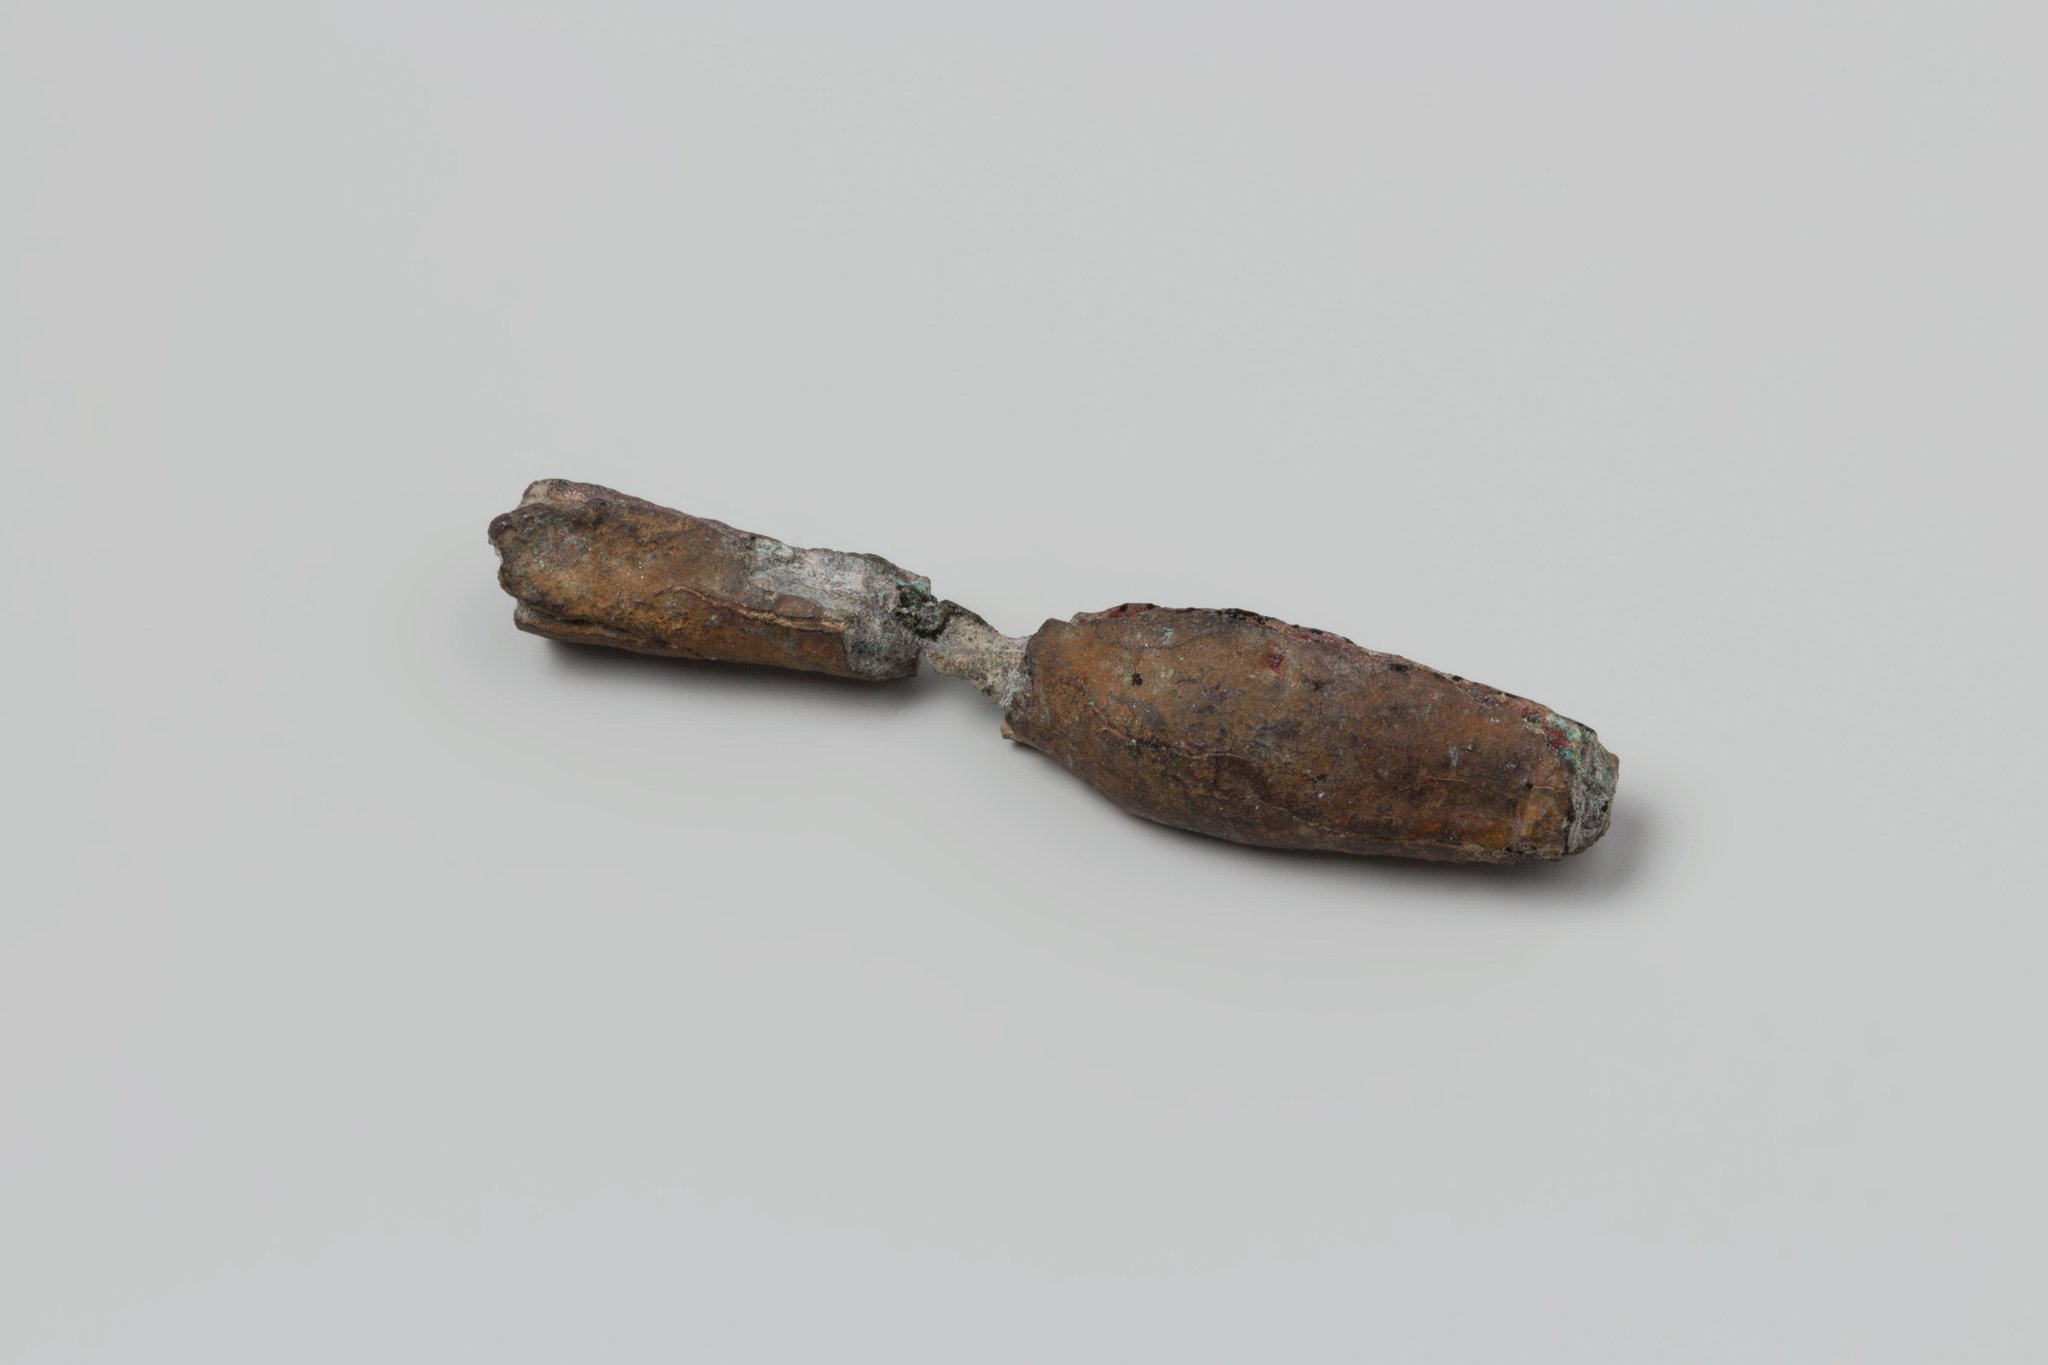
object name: spoon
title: Fragment steel van vork of lepel uit het wrak van de Oost-Indiëvaarder Hollandia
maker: Anonymous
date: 1700-1743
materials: tin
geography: netherlands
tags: verenigde oostindische compagnie, hollandia (schip), annet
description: Cutlery, fragment: stem of fork or spoon; fragm, heavily corroded.